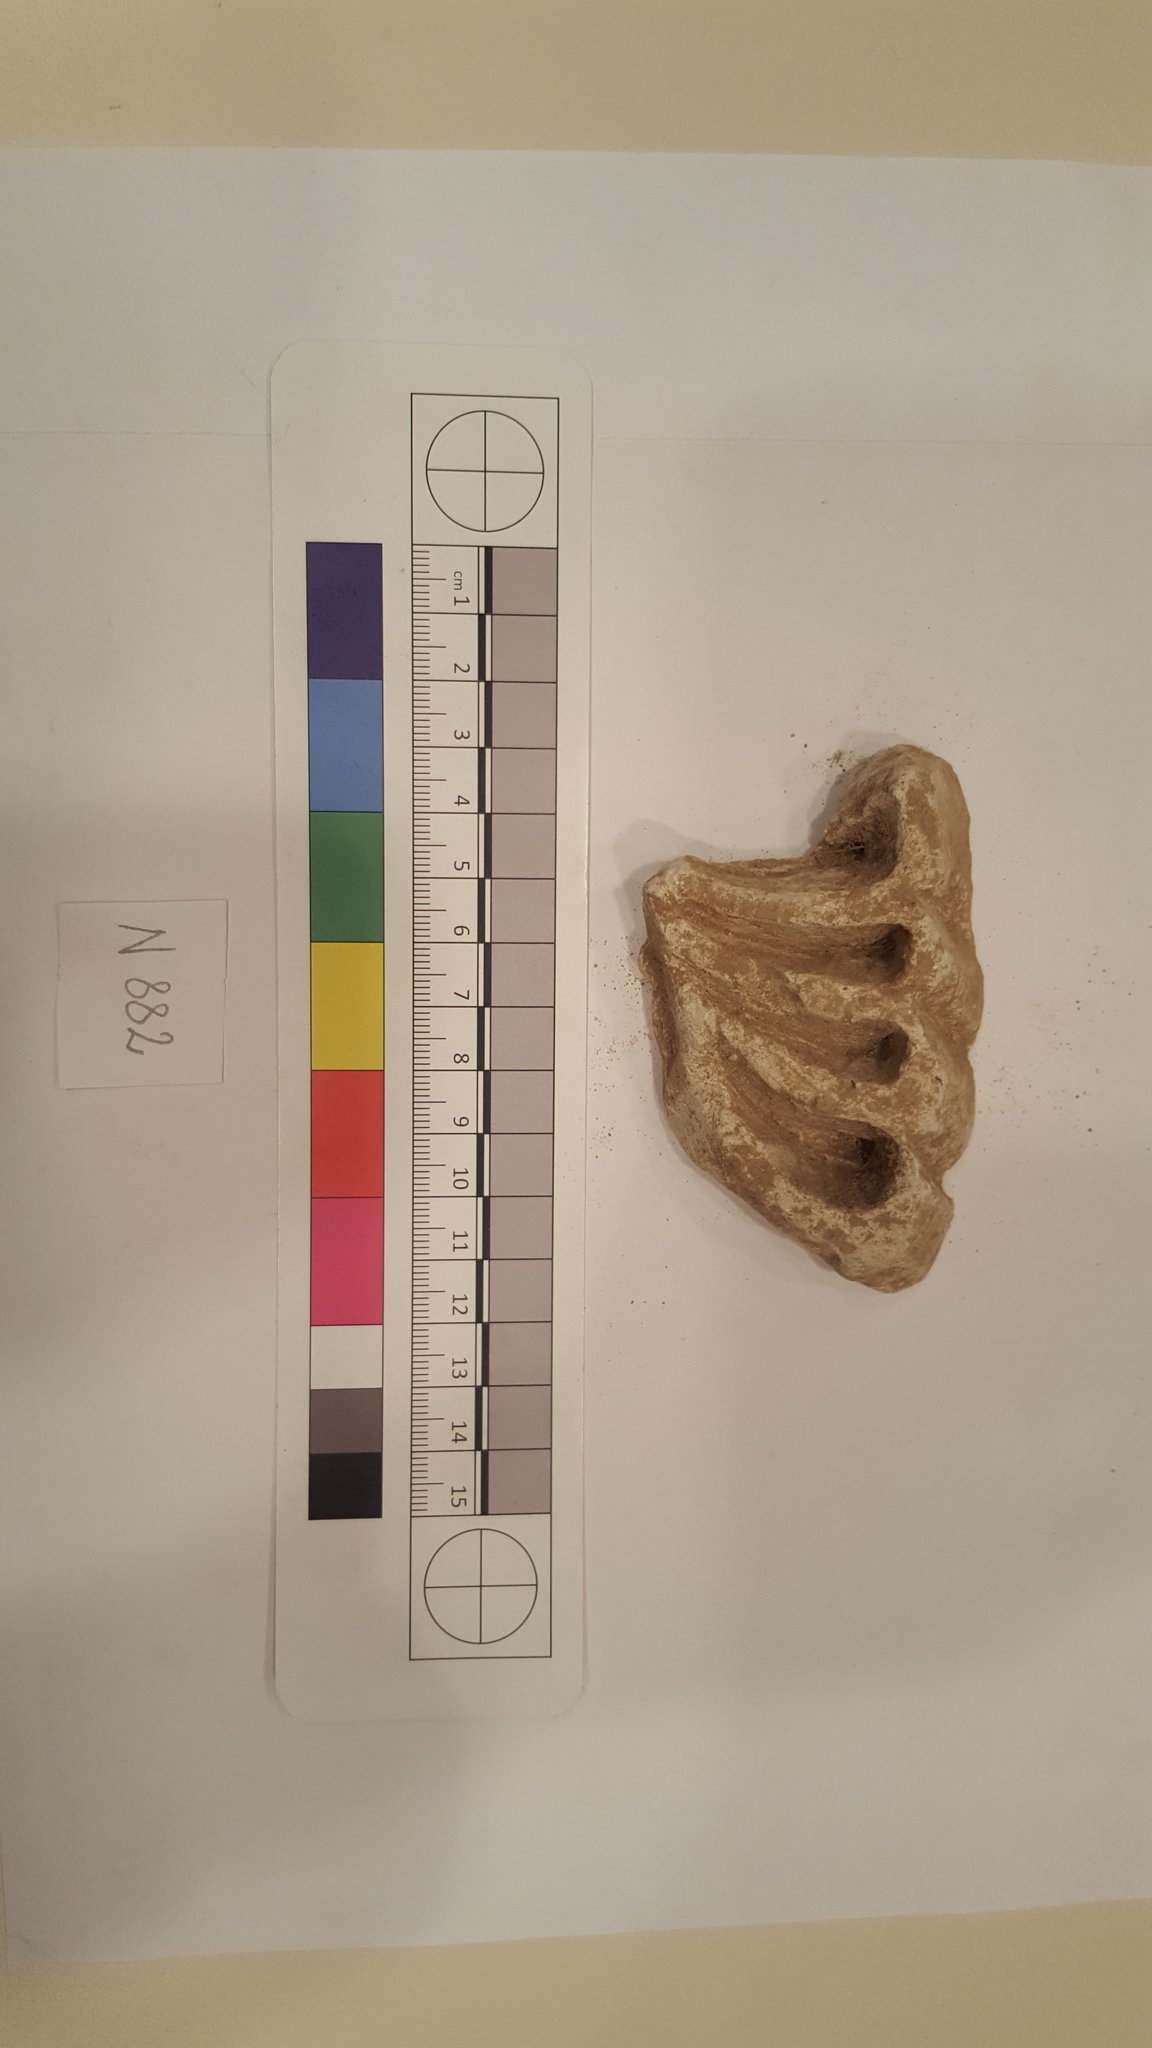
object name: fragment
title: Stucco Fragment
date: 701-1200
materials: plaster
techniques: carving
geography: iran